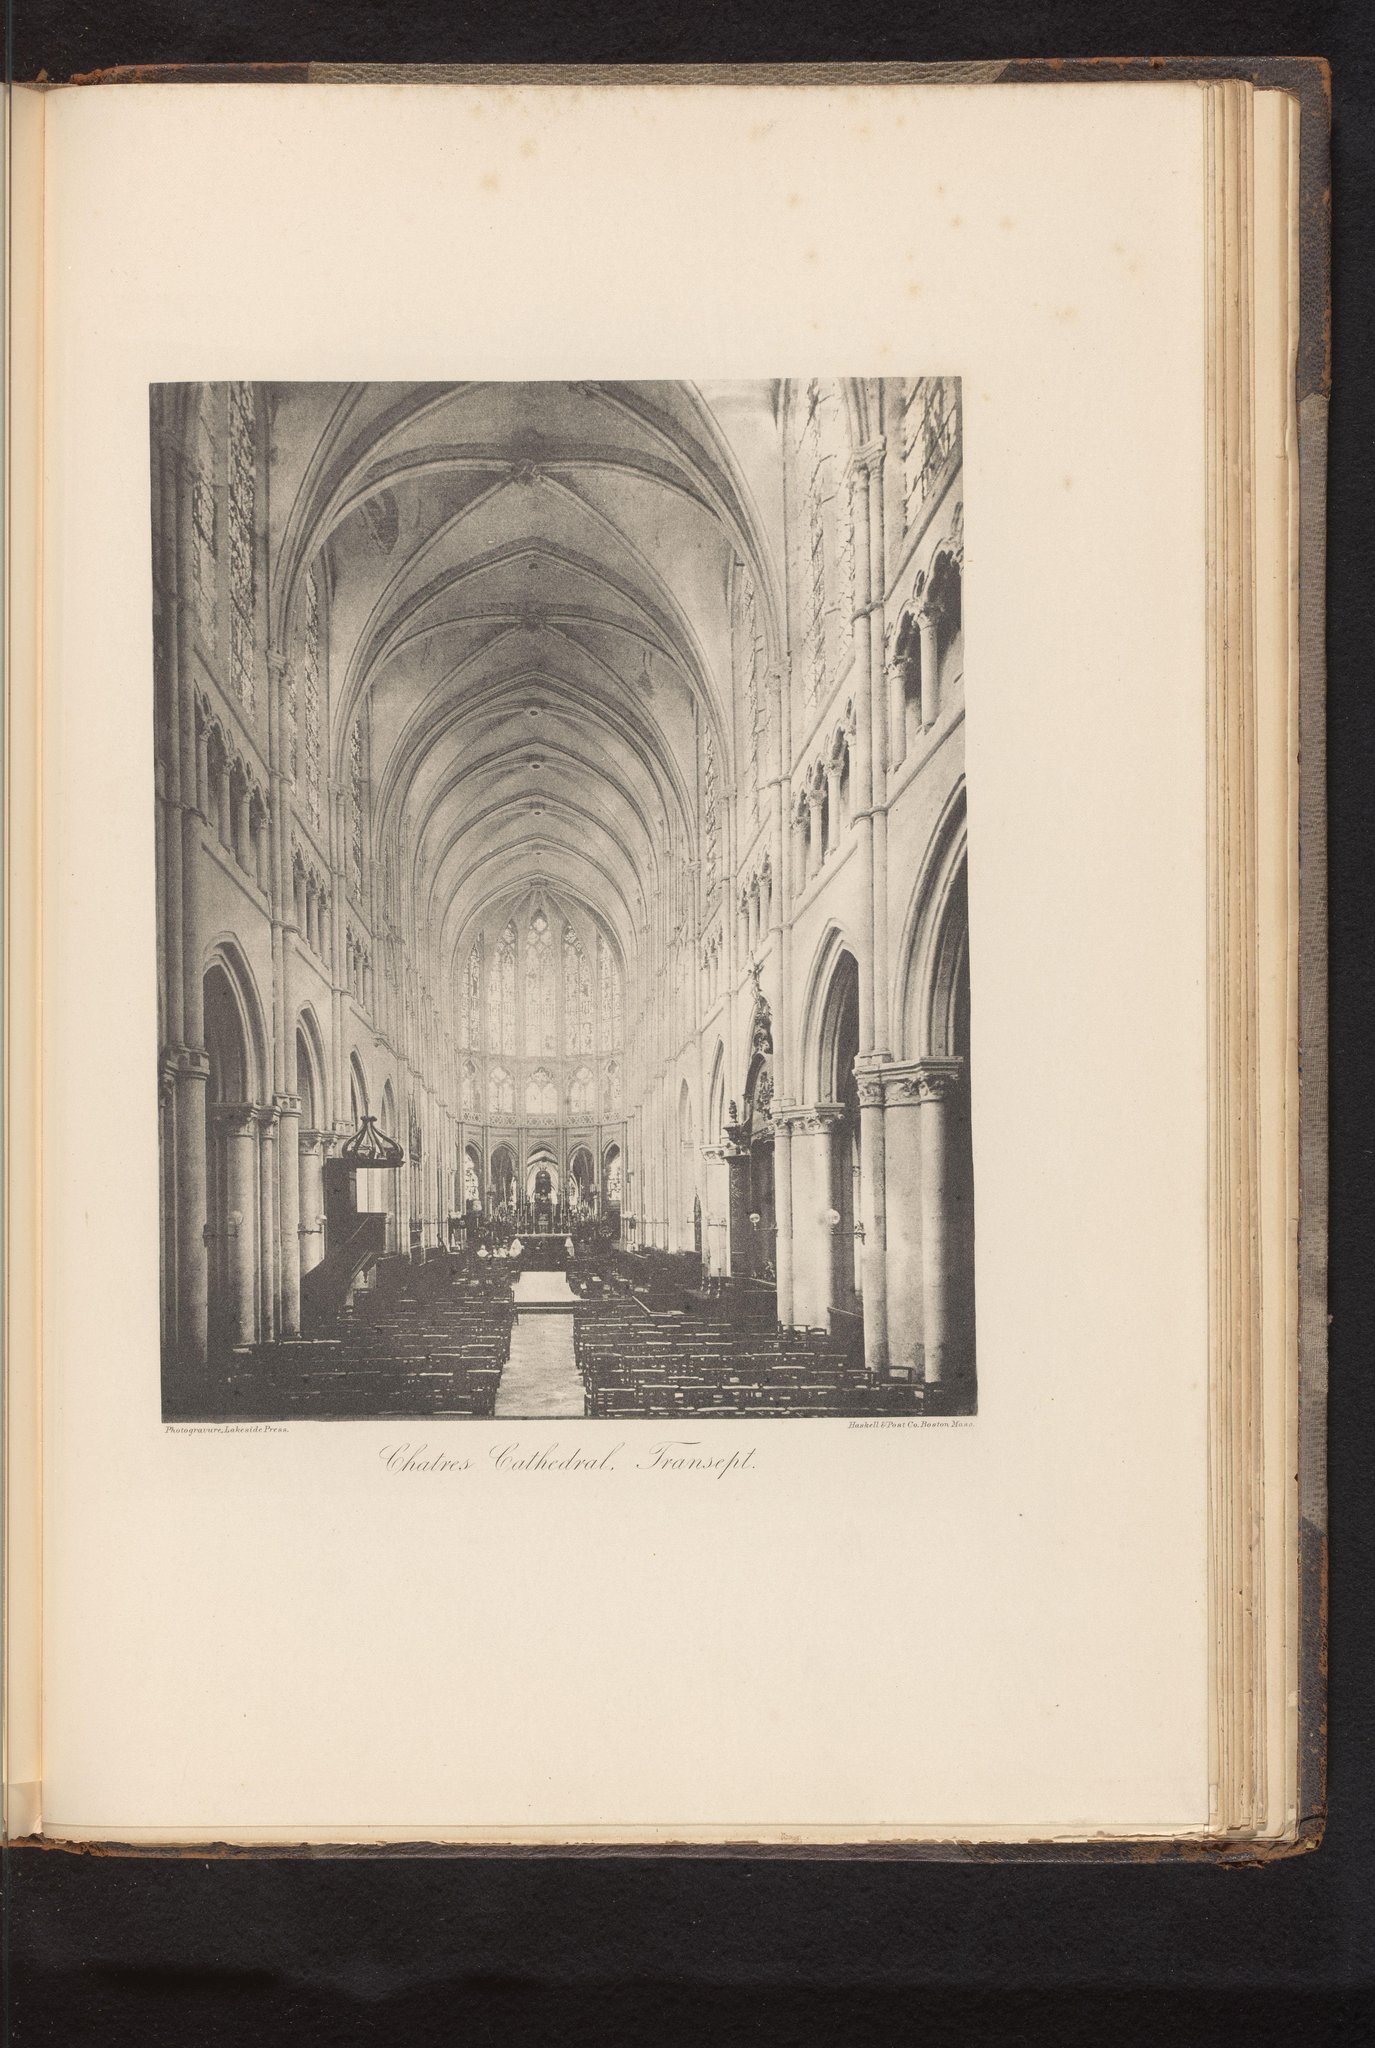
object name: photomechanical print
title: Interieur van de kathedraal van Chartres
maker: Anonymous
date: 1881-1886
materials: paper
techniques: photograph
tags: parts of church interior: transept